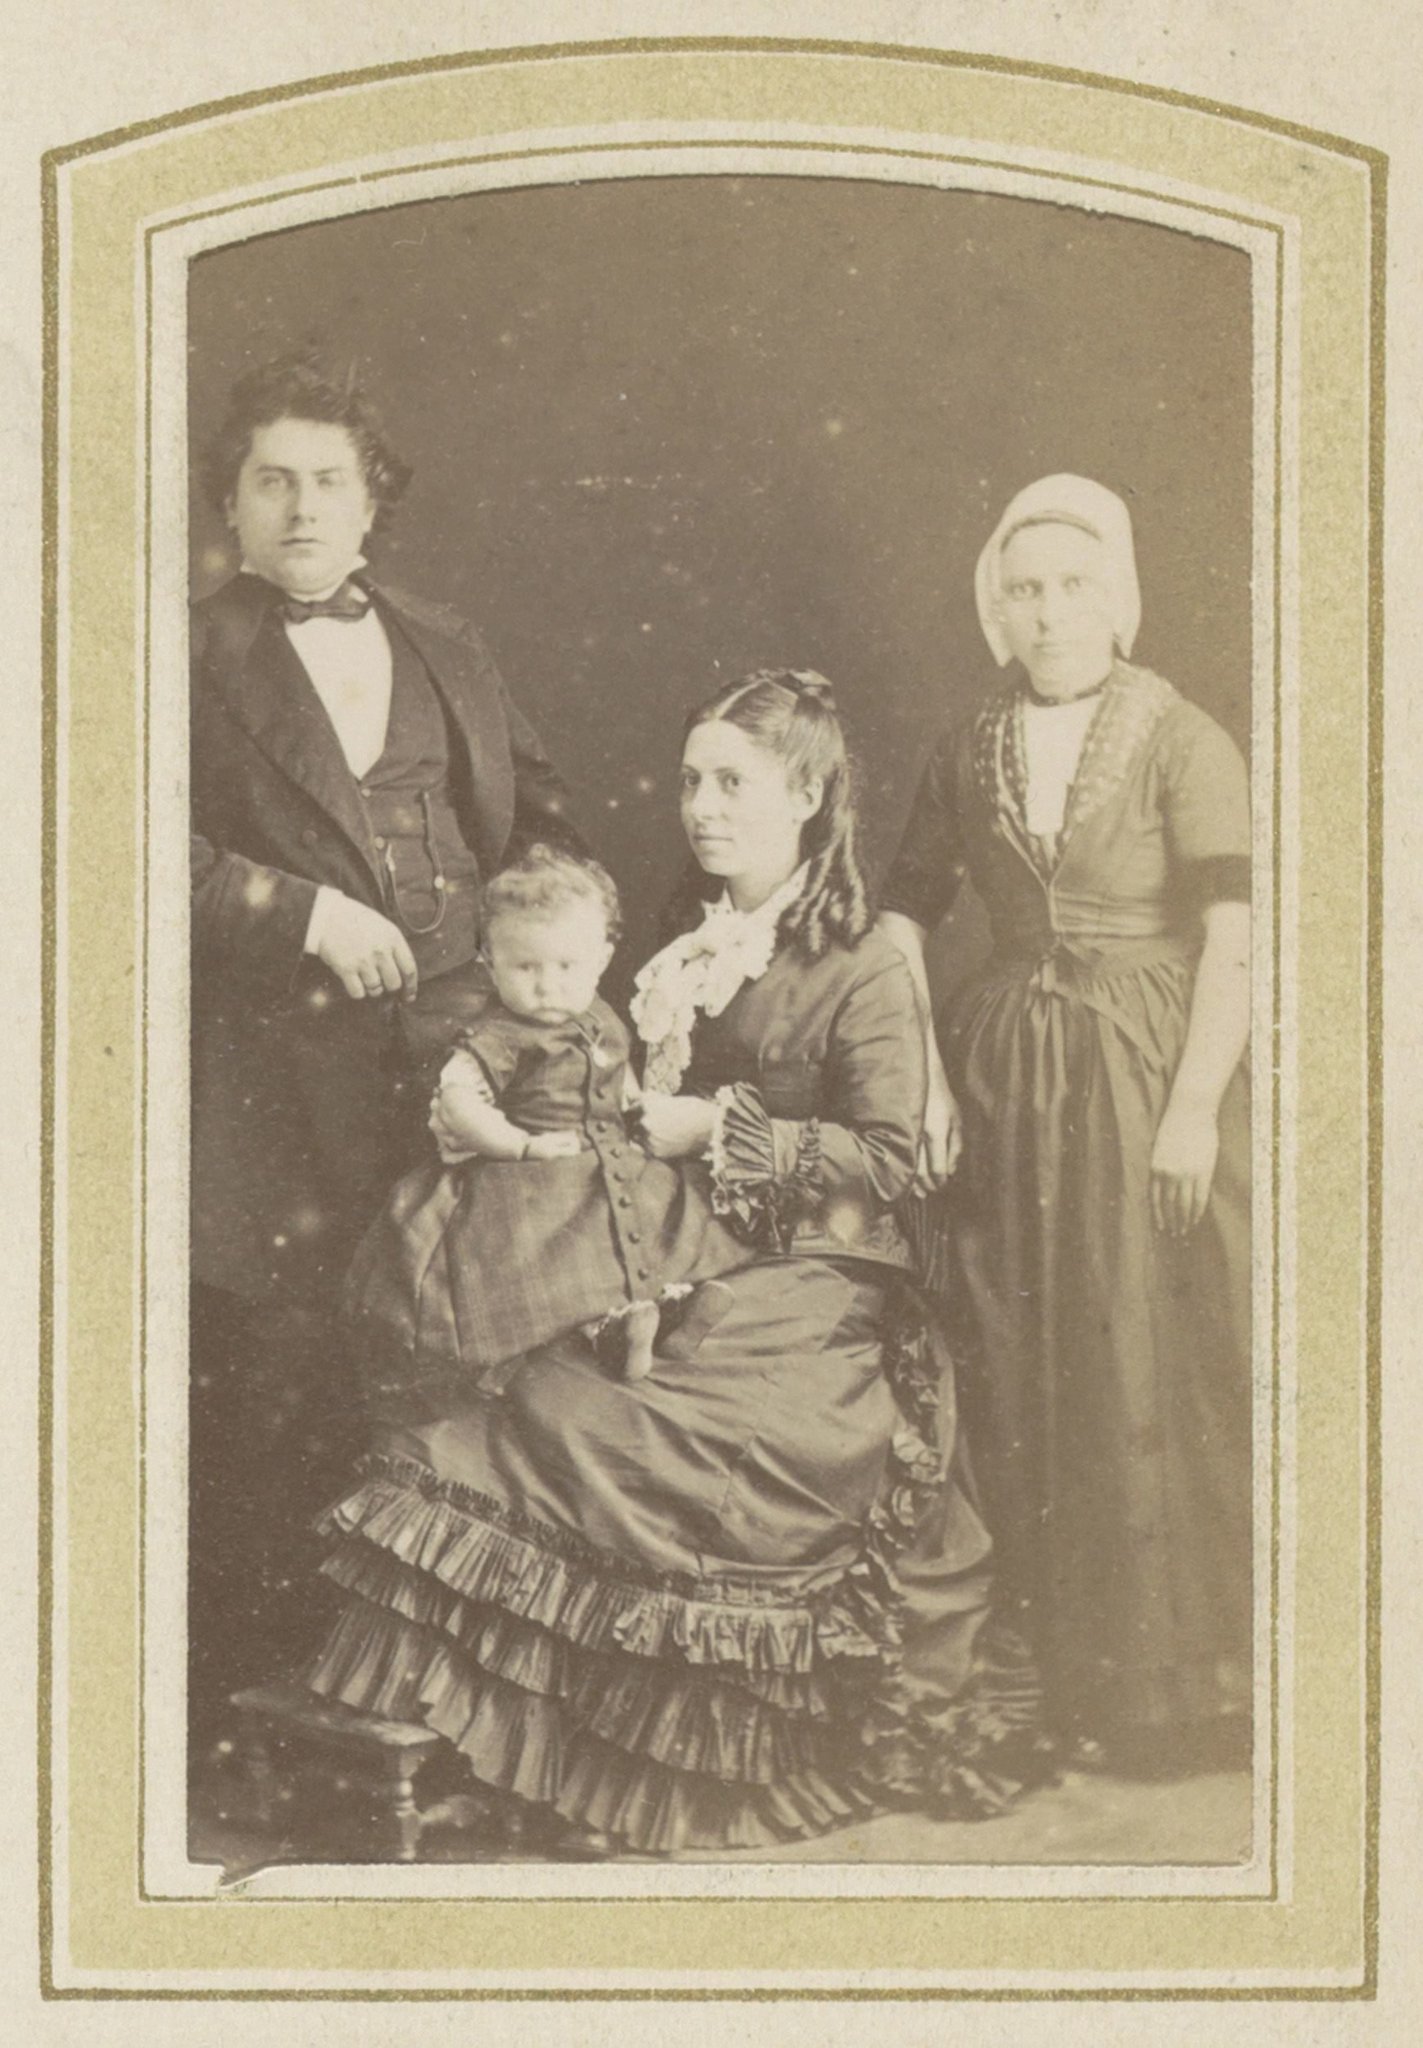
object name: photograph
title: Portret van een man, een baby en twee vrouwen, de één in een jurk, de ander met een muts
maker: carl wilhelm bauer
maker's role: fotograaf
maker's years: 1844-1911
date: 1879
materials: cardboard, paper, photographic support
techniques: albumen print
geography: middelburg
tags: studio requisites ~ photographer, clothing for the lower part of the body, head-gear, child, historical persons, clothing for the upper part of the body, infant, baby ~ the ages of man, middelburg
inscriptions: address: ‘Middelburg’, inscription: ‘1879’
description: Onderdeel van Fotoalbum van een Nederlandse familie met 168 cartes-de-visite en kabinetfoto's.